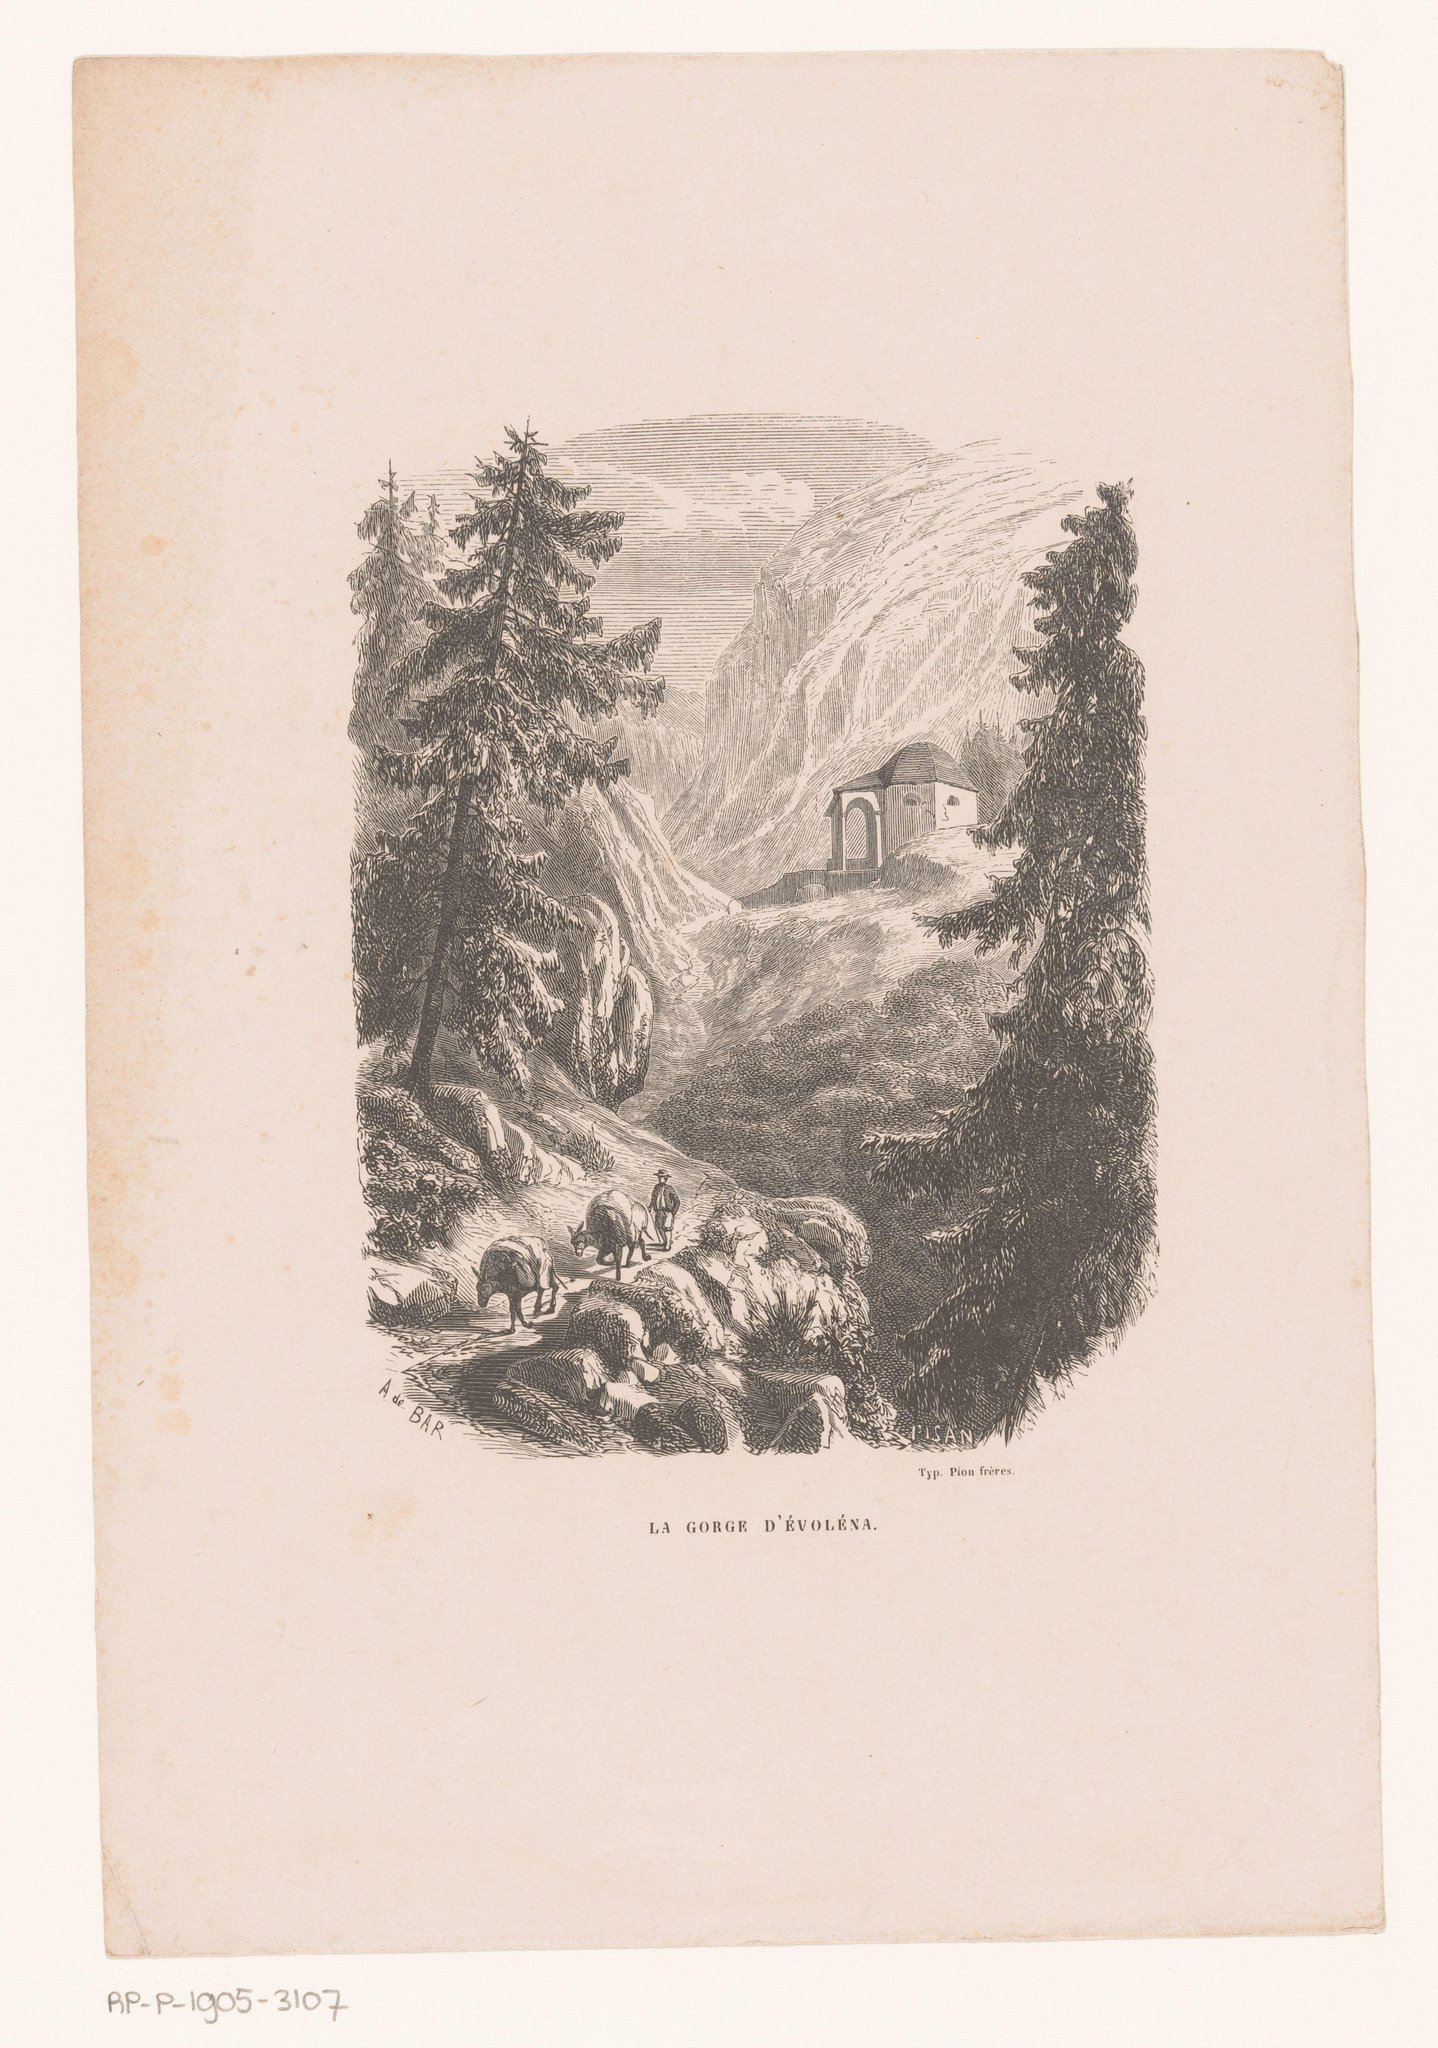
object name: print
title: La gorge d'Evolena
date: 1832-1890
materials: paper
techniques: engraving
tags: pack-animal, dale, valley, switzerland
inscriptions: collector's mark: Lugt 2228